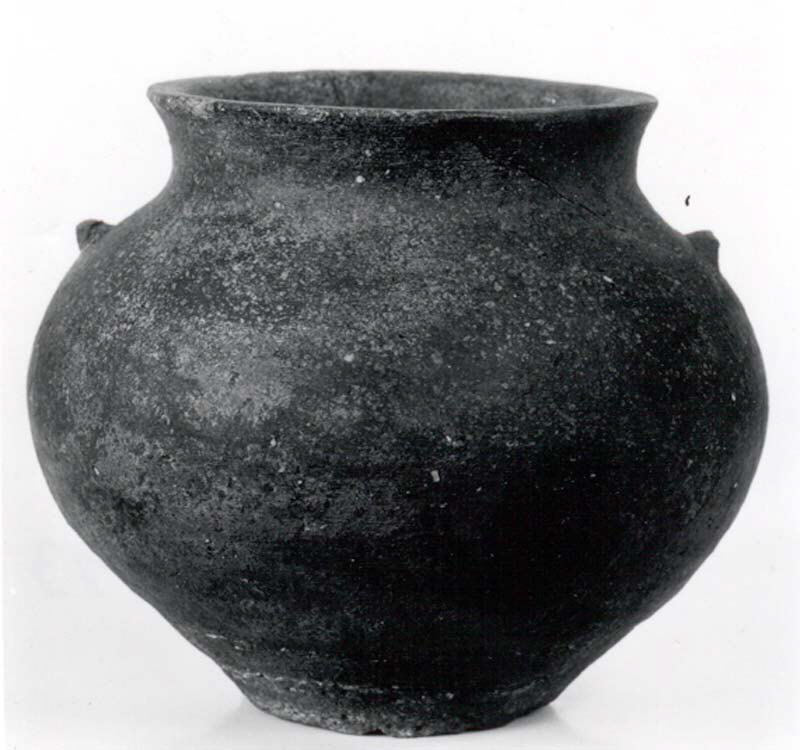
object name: jar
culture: sasanian or islamic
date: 501-800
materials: ceramic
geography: iran